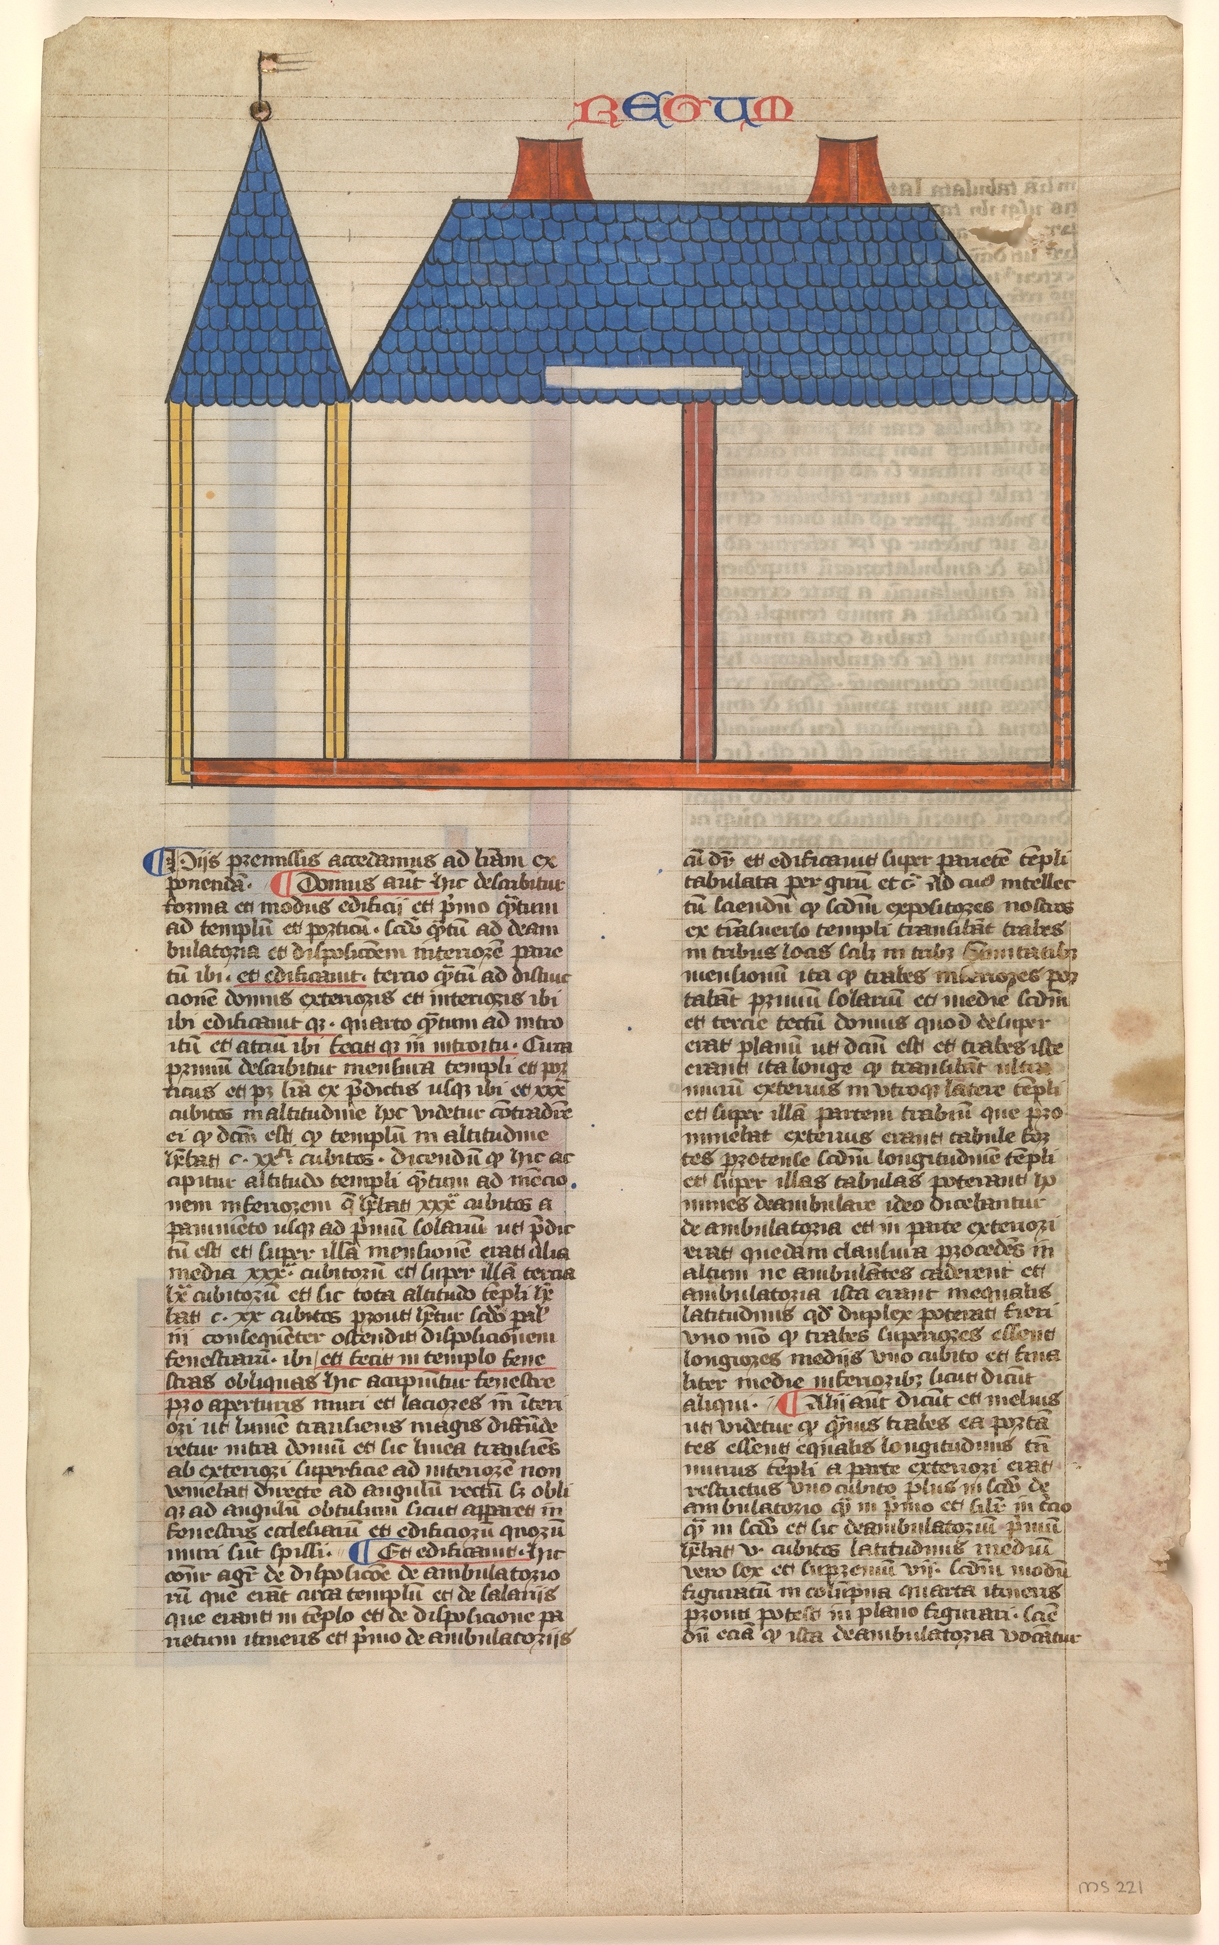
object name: manuscript leaf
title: Elevation of Solomon's Temple, one of six illustrated leaves from the Postilla Litteralis (Literal Commentary) of Nicholas of Lyra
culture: french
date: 1360-1380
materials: gold, ink, iron, parchment, watercolor